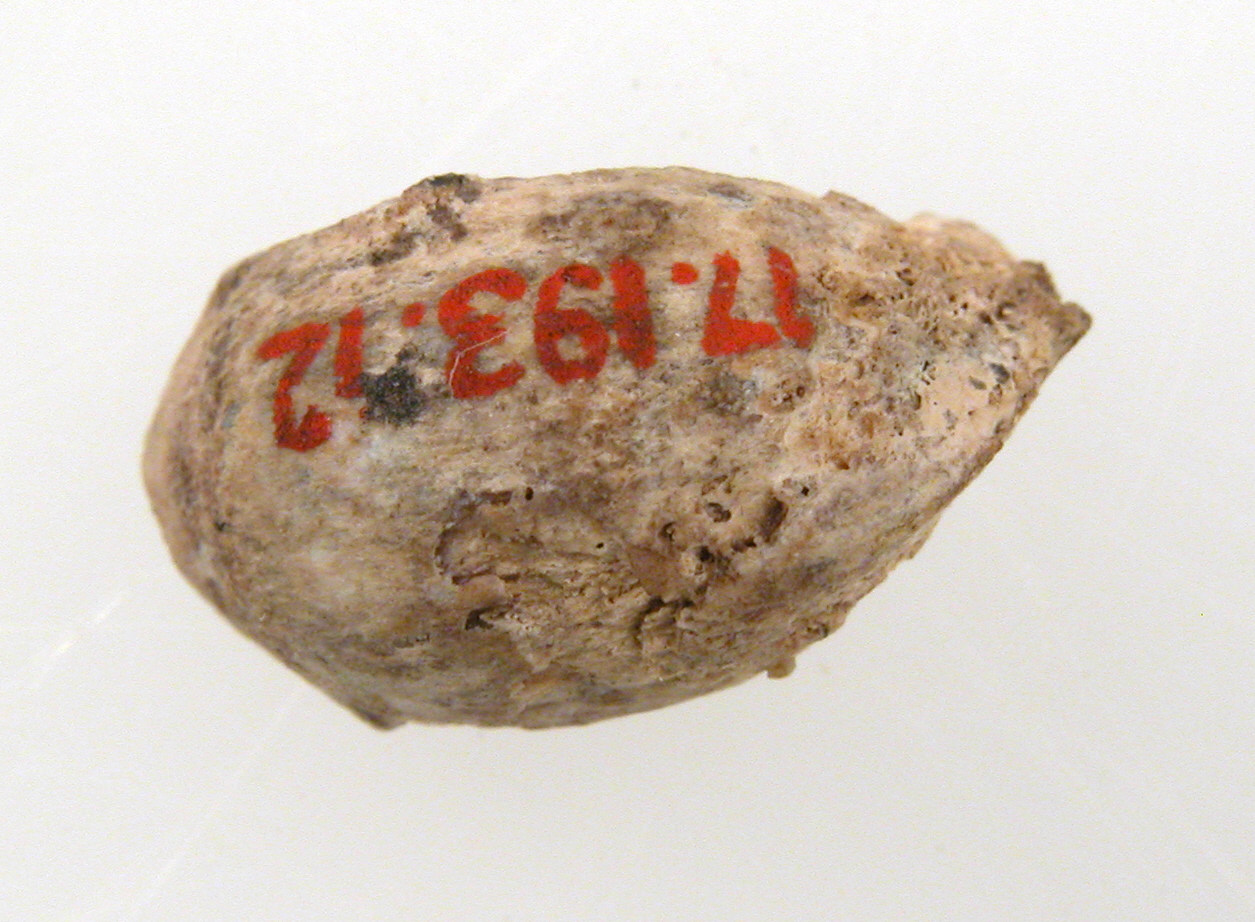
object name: cherry stone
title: Cherry Stone from a Tomb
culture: frankish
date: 500-600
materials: stone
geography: niederbreisig